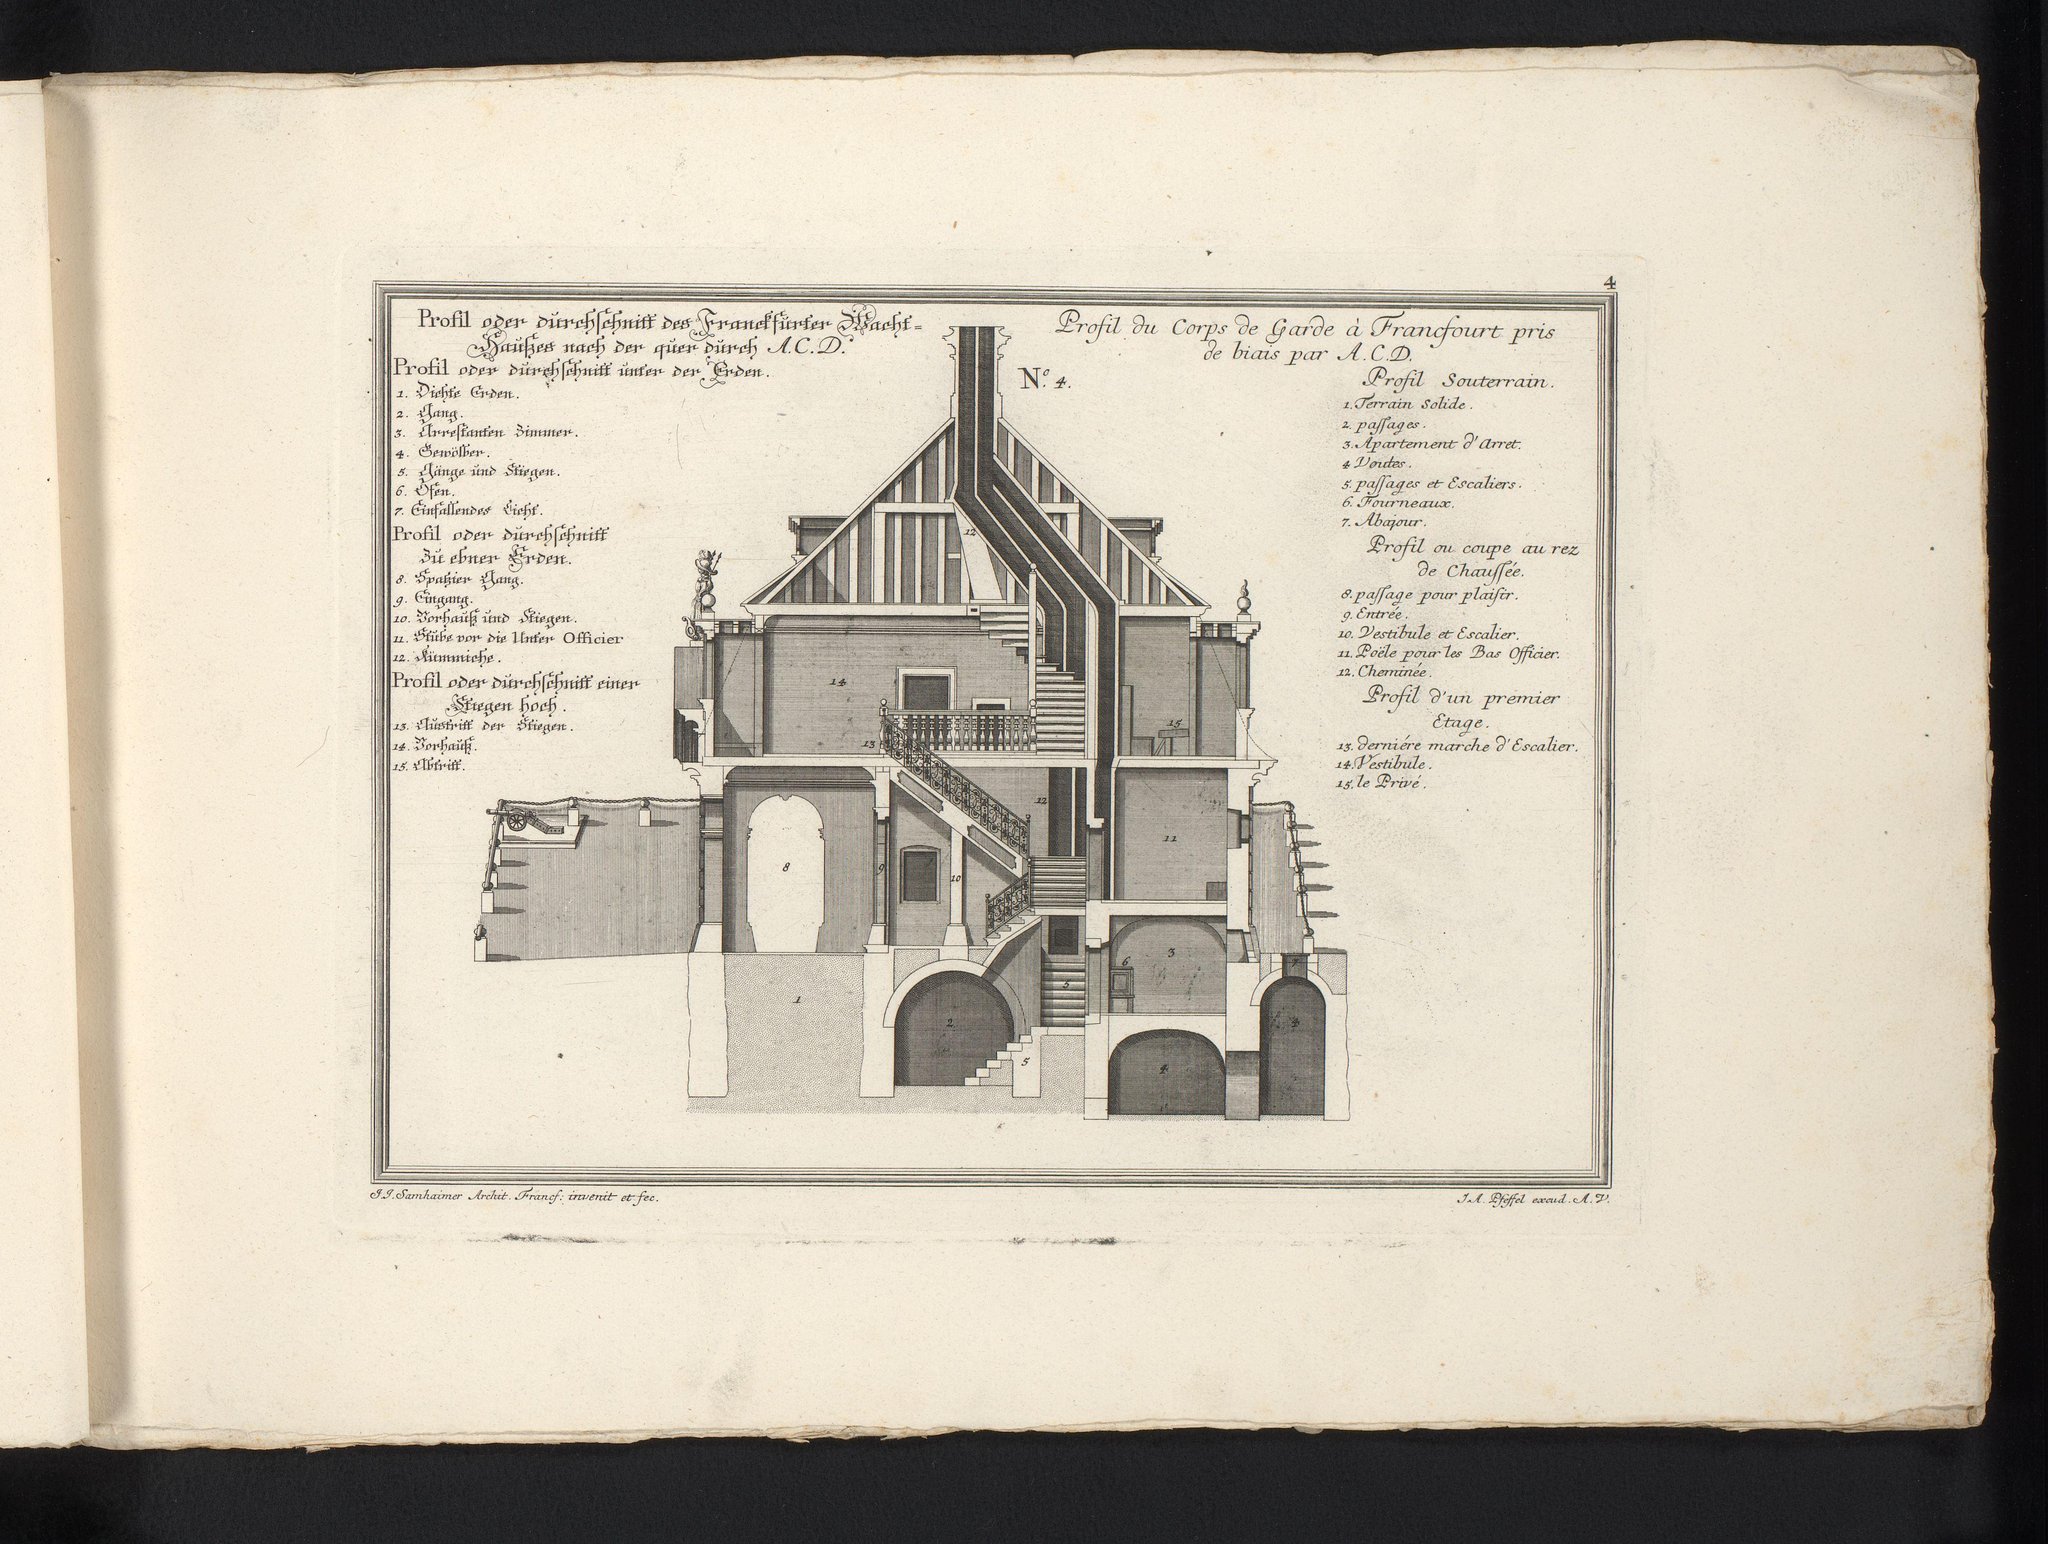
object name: print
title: Profil oder dürchschnitt des Franckfurter (...) / Profildu corps de garde à Francfourt (...)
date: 1729-1730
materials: paper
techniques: engraving, etching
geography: frankfurt am main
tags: prison, jail, barracks, plan ~ architecture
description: Boven, in het midden, en rechtsboven genummerd: 4.